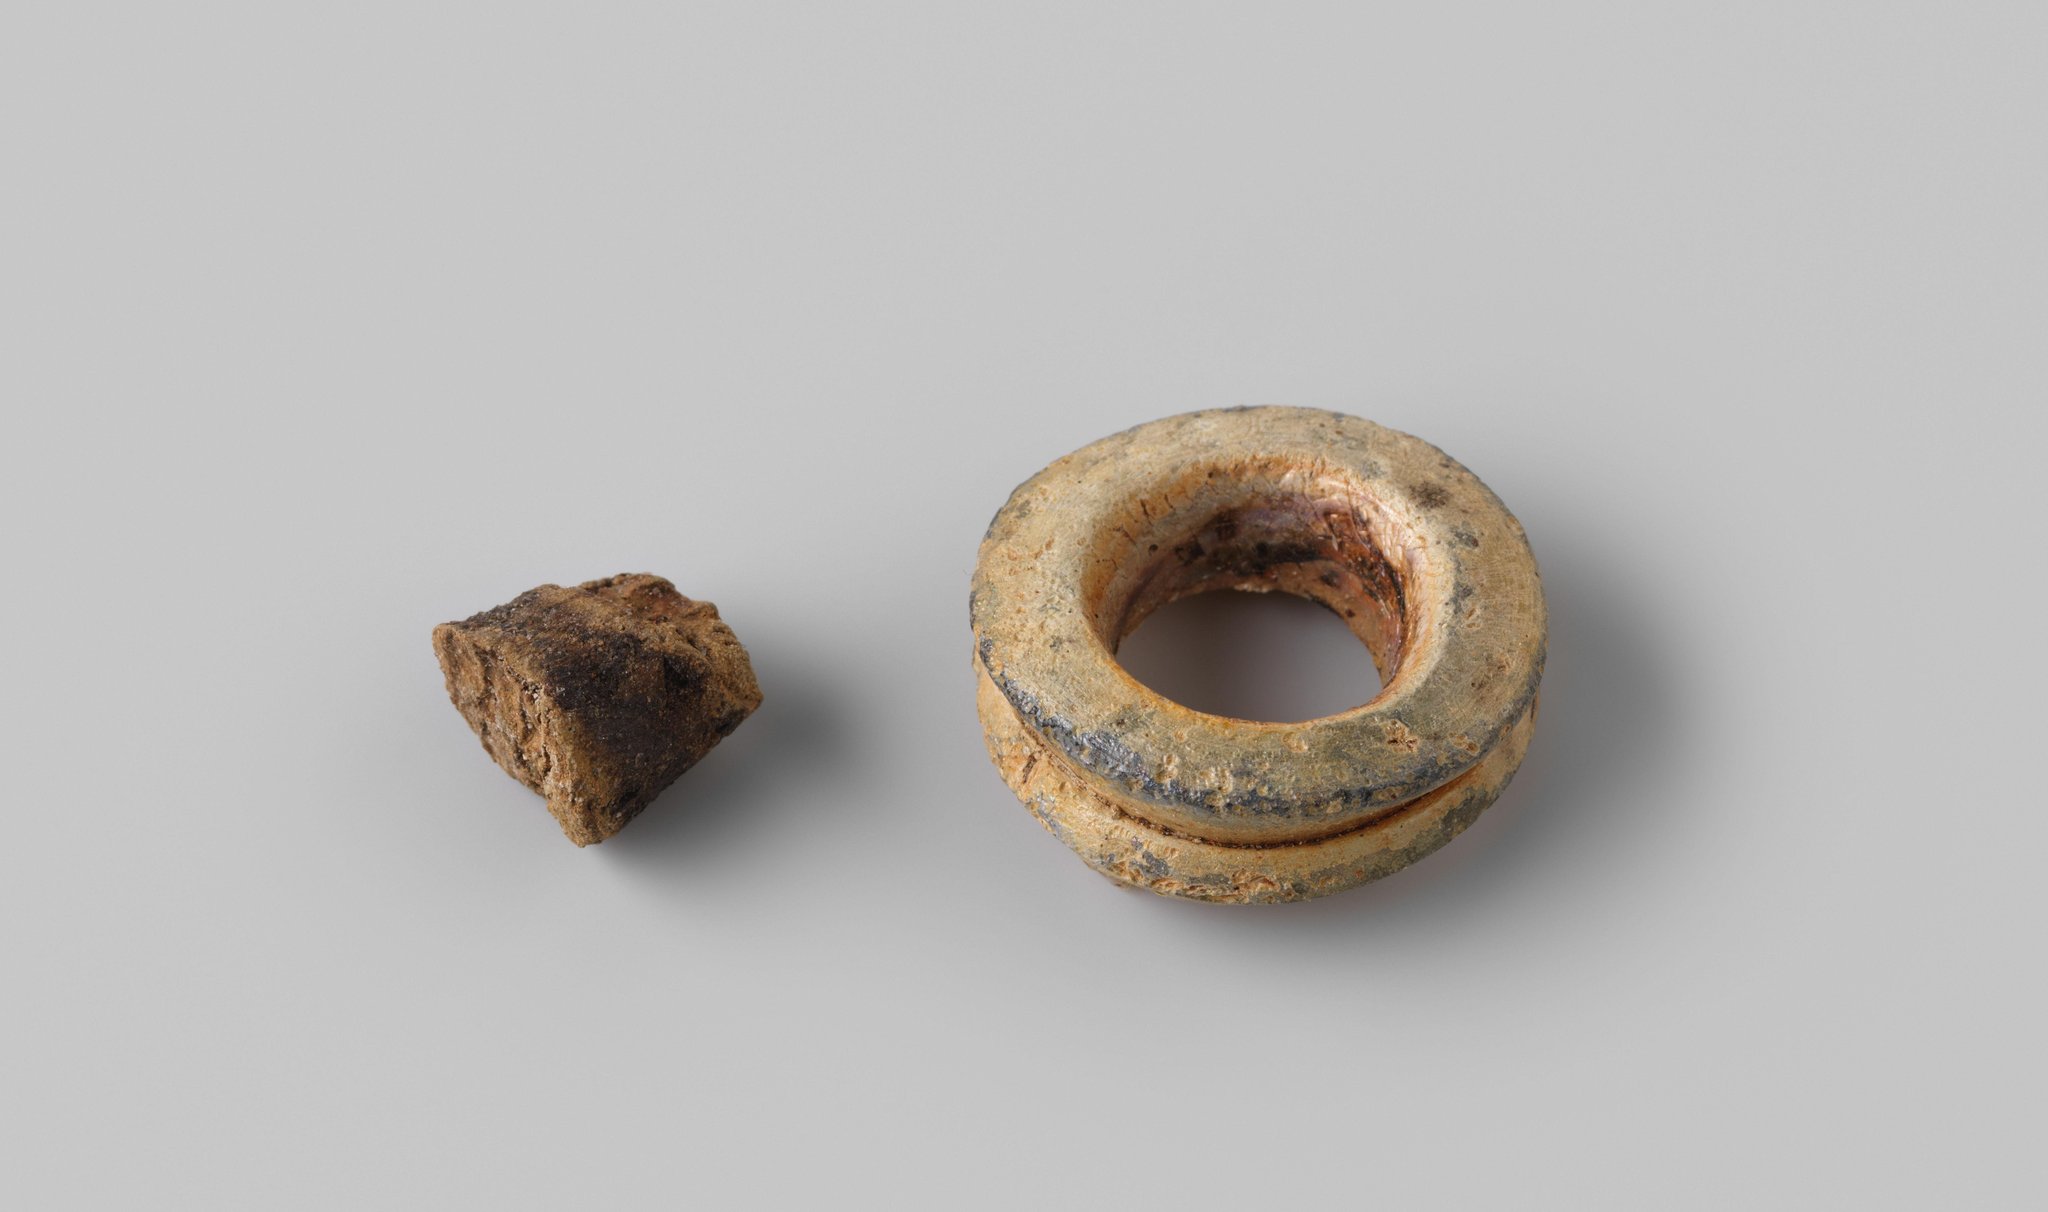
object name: sherd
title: Hals met kurk van een wijnfles uit het wrak van de Oost-Indiëvaarder Hollandia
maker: Anonymous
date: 1700-1743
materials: cork, glass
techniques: green glass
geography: netherlands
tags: verenigde oostindische compagnie, hollandia (schip), annet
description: Wine bottle, continental production, neck, onion-shaped bottle or bottle with vertical side; fragm, mouth, vs-string rim.